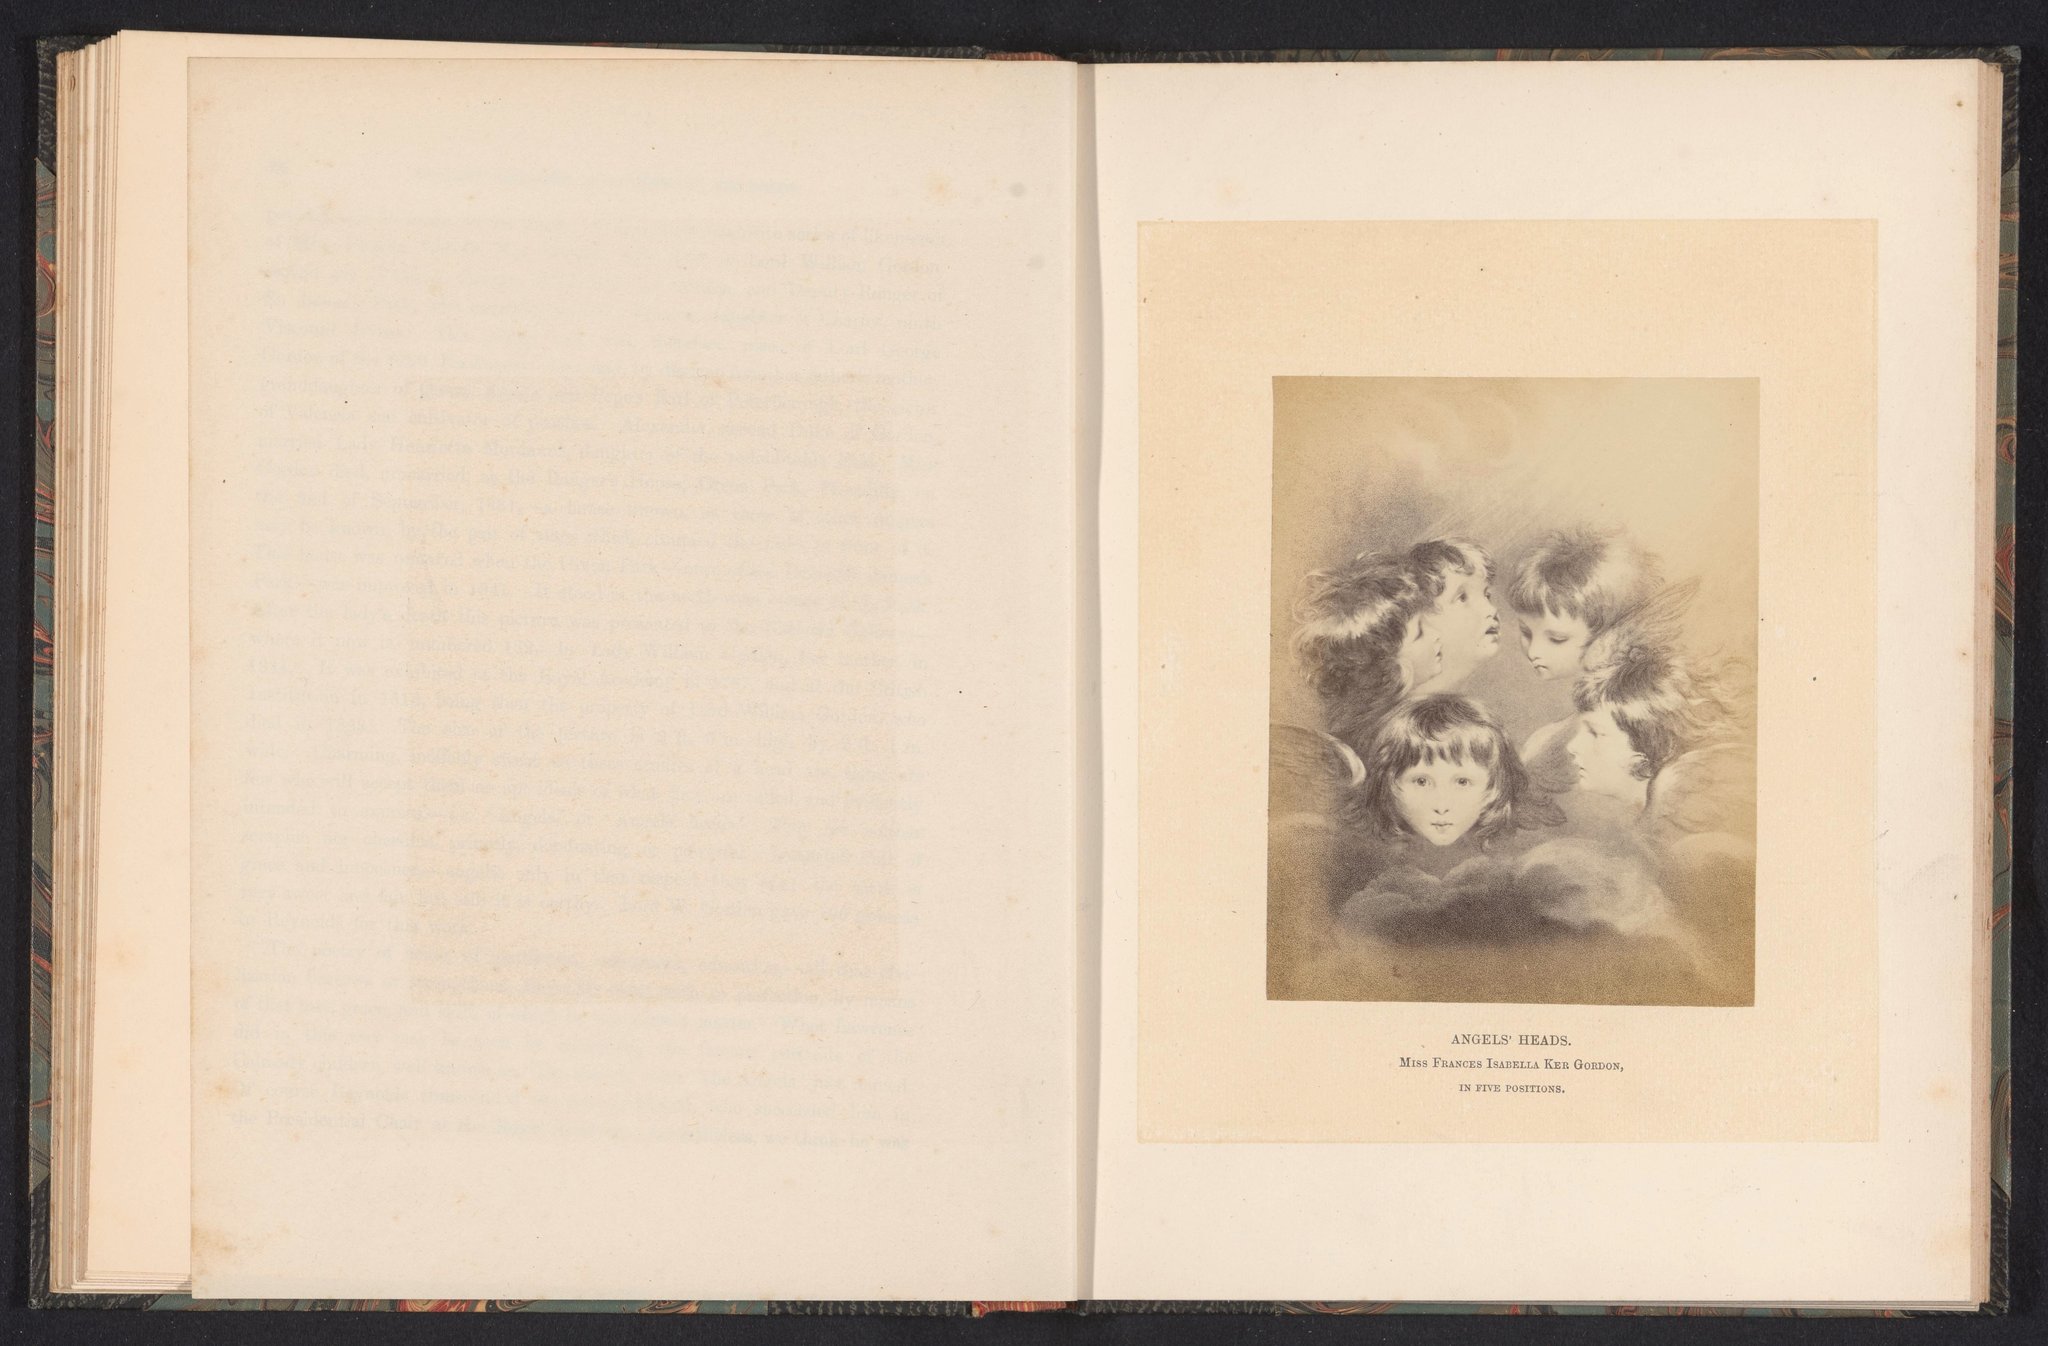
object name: photograph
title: Angels' Head. Miss Frances Isabella Ker Gordon, in five Positions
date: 1857-1867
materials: photographic support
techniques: albumen print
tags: picture, painting, angels